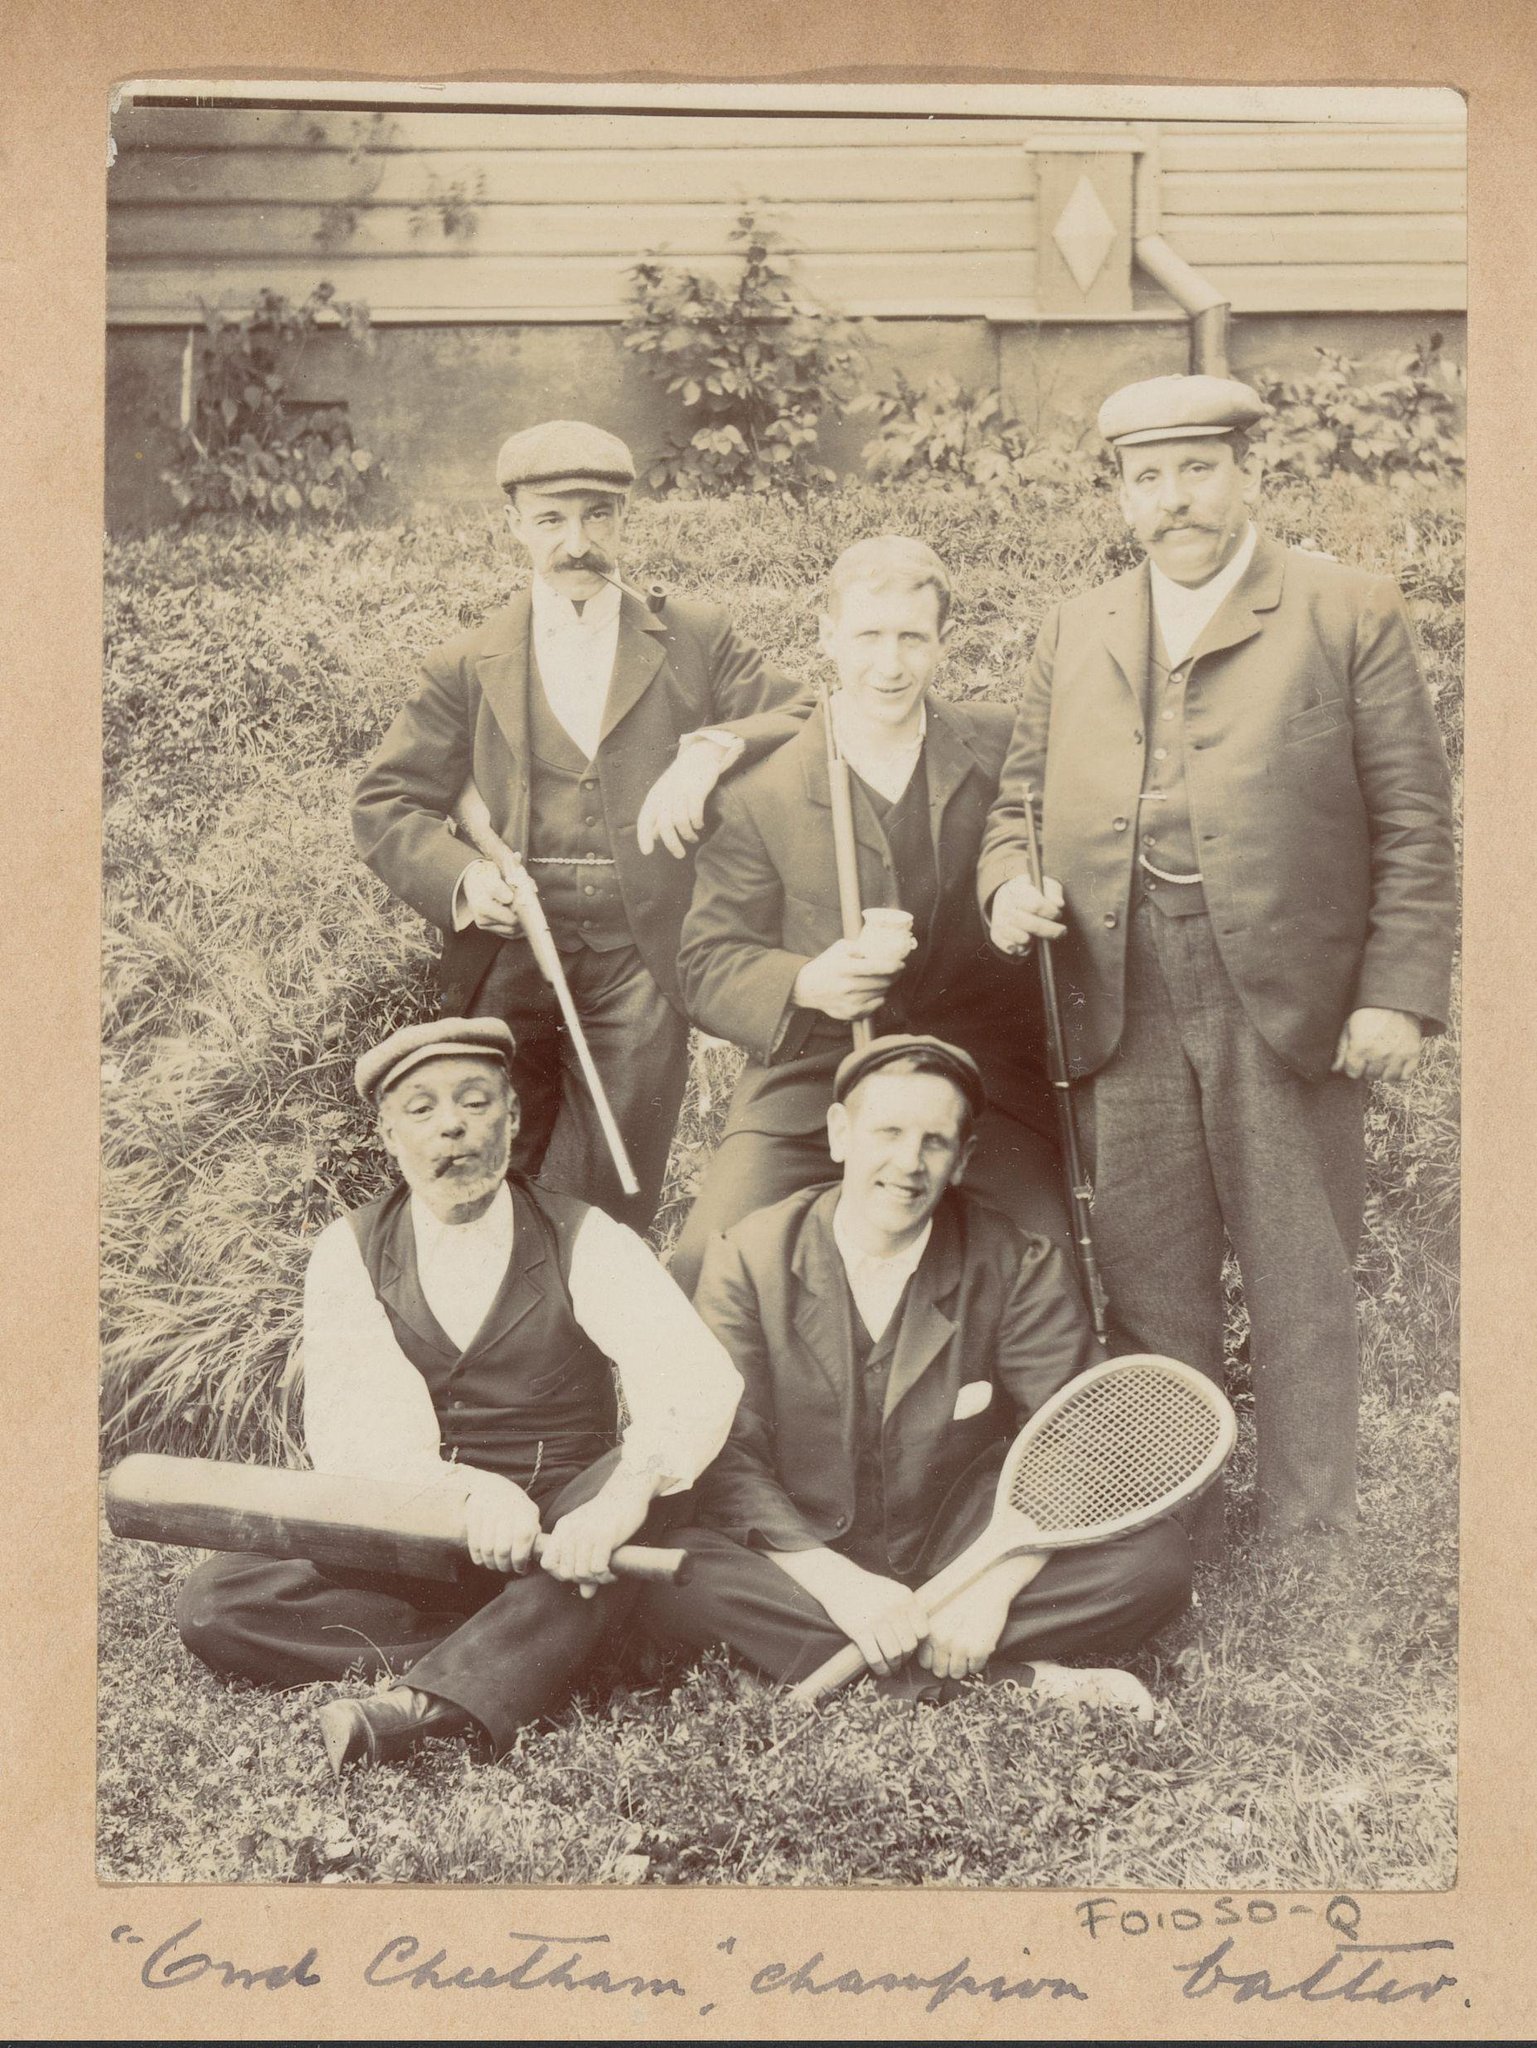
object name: photograph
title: Groep mannen waaronder Joseph Cheetham (linksvoor) met tennisracket, cricketbat en jachtgeweren in Rusland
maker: joseph cheetham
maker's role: engineer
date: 1903-1904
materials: photographic support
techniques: gelatin silver print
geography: russia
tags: engineer, joseph cheetham, tennis, lawn-tennis, cricket (ball game), adult man, firearms: rifle, russia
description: Vermoedelijk betreft het hier Engelse vrienden van Joseph Cheetham. Vergelijk foto RP-F-F01050-W. Fotoalbum van de Engelse familie Cheetham met opnames van hun verblijf in Rusland.